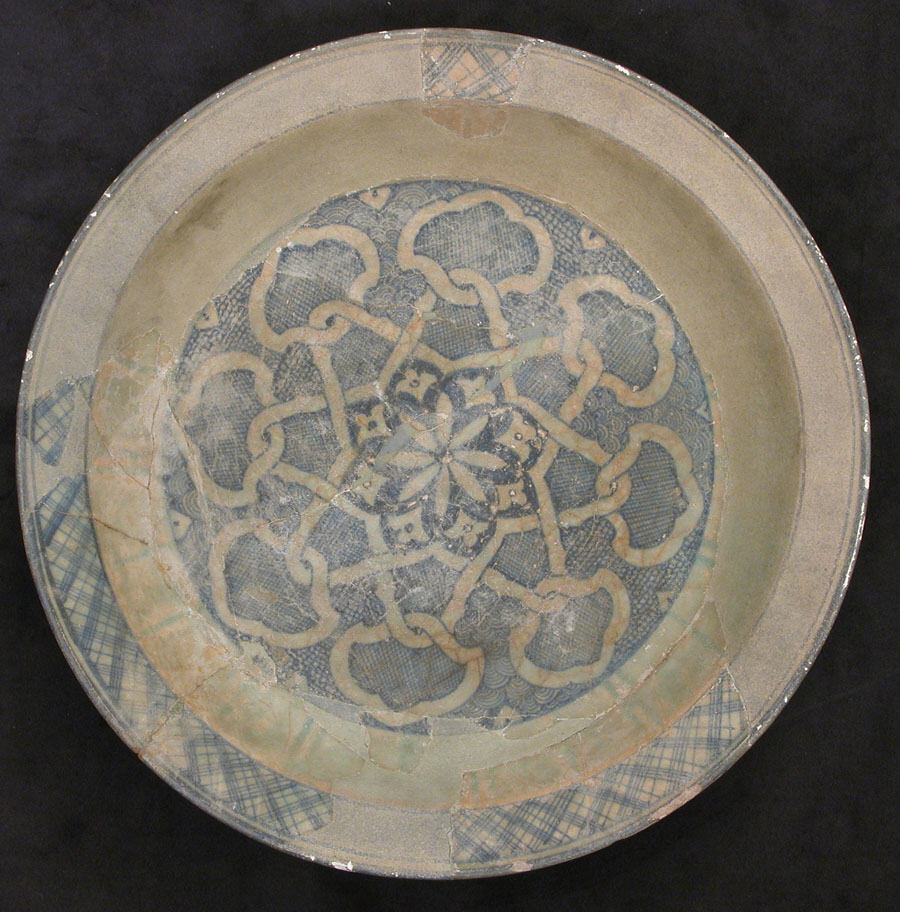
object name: dish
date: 1301-1400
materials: earthenware, glaze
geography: iran